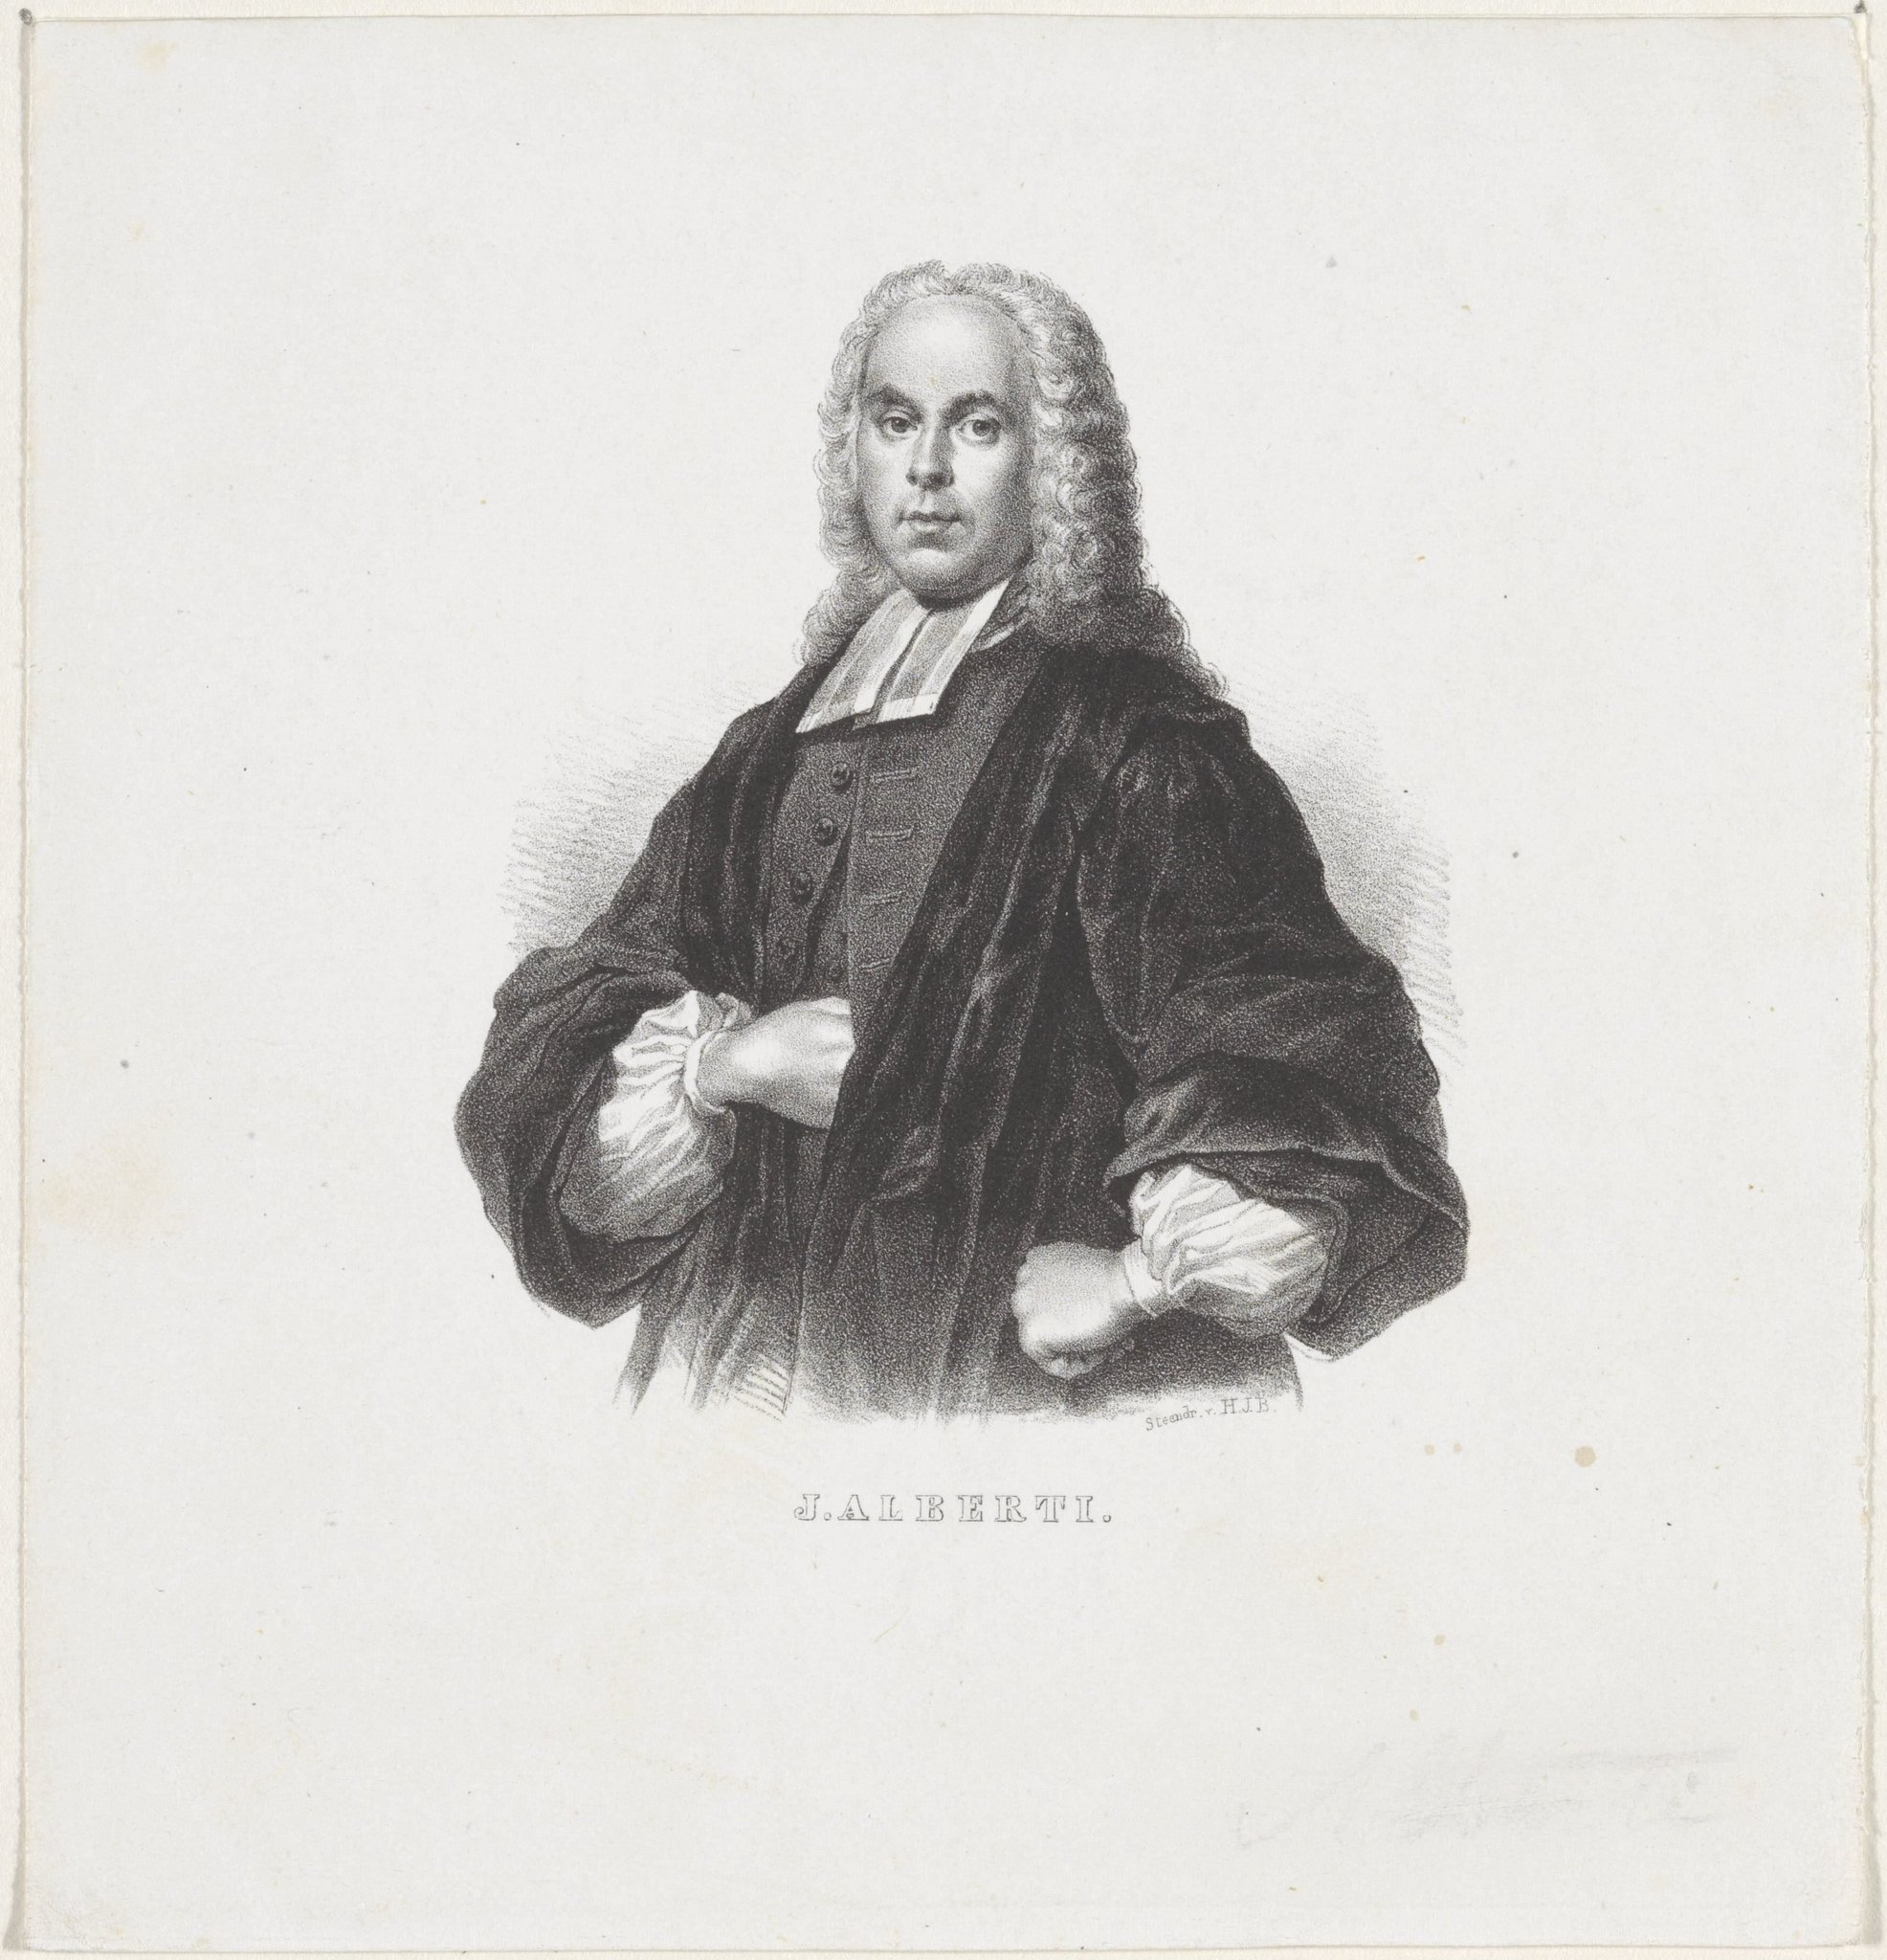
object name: print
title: Portret van hoogleraar Johannes Alberti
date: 1822-1845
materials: paper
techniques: lithograph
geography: dordrecht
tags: leiden, historical persons, professor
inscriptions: collector's mark: Lugt 2228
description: De geportretteerde heeft een hand in zijn jas gestoken.